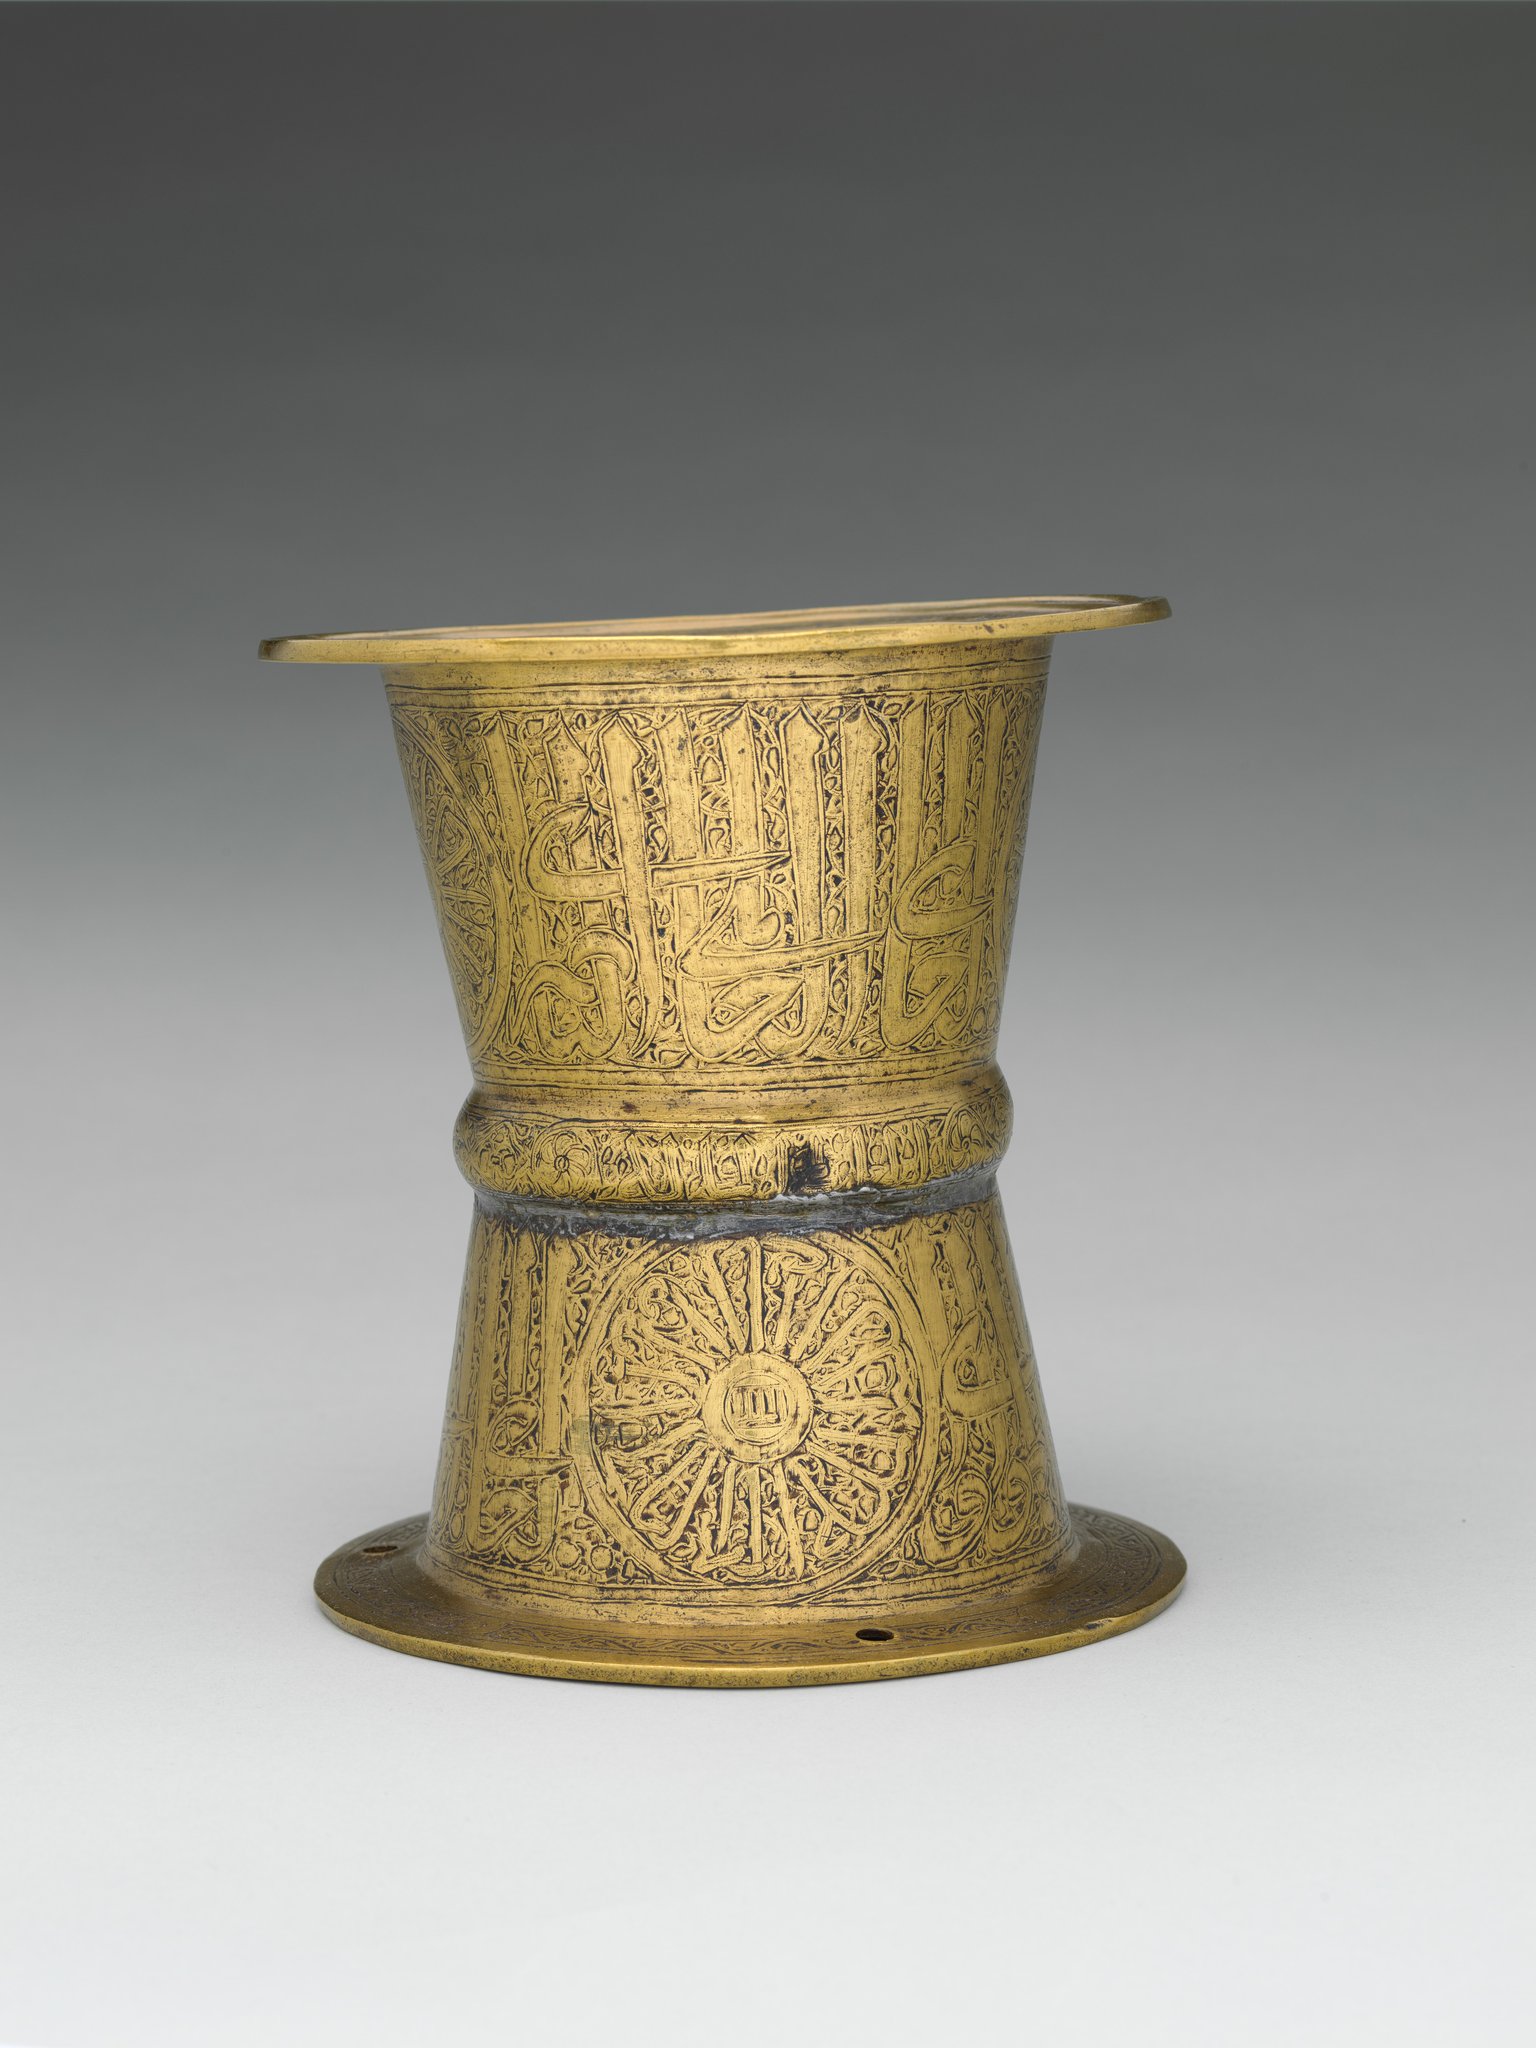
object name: stand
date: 1301-1350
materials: brass, silver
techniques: inlay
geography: egypt or syria